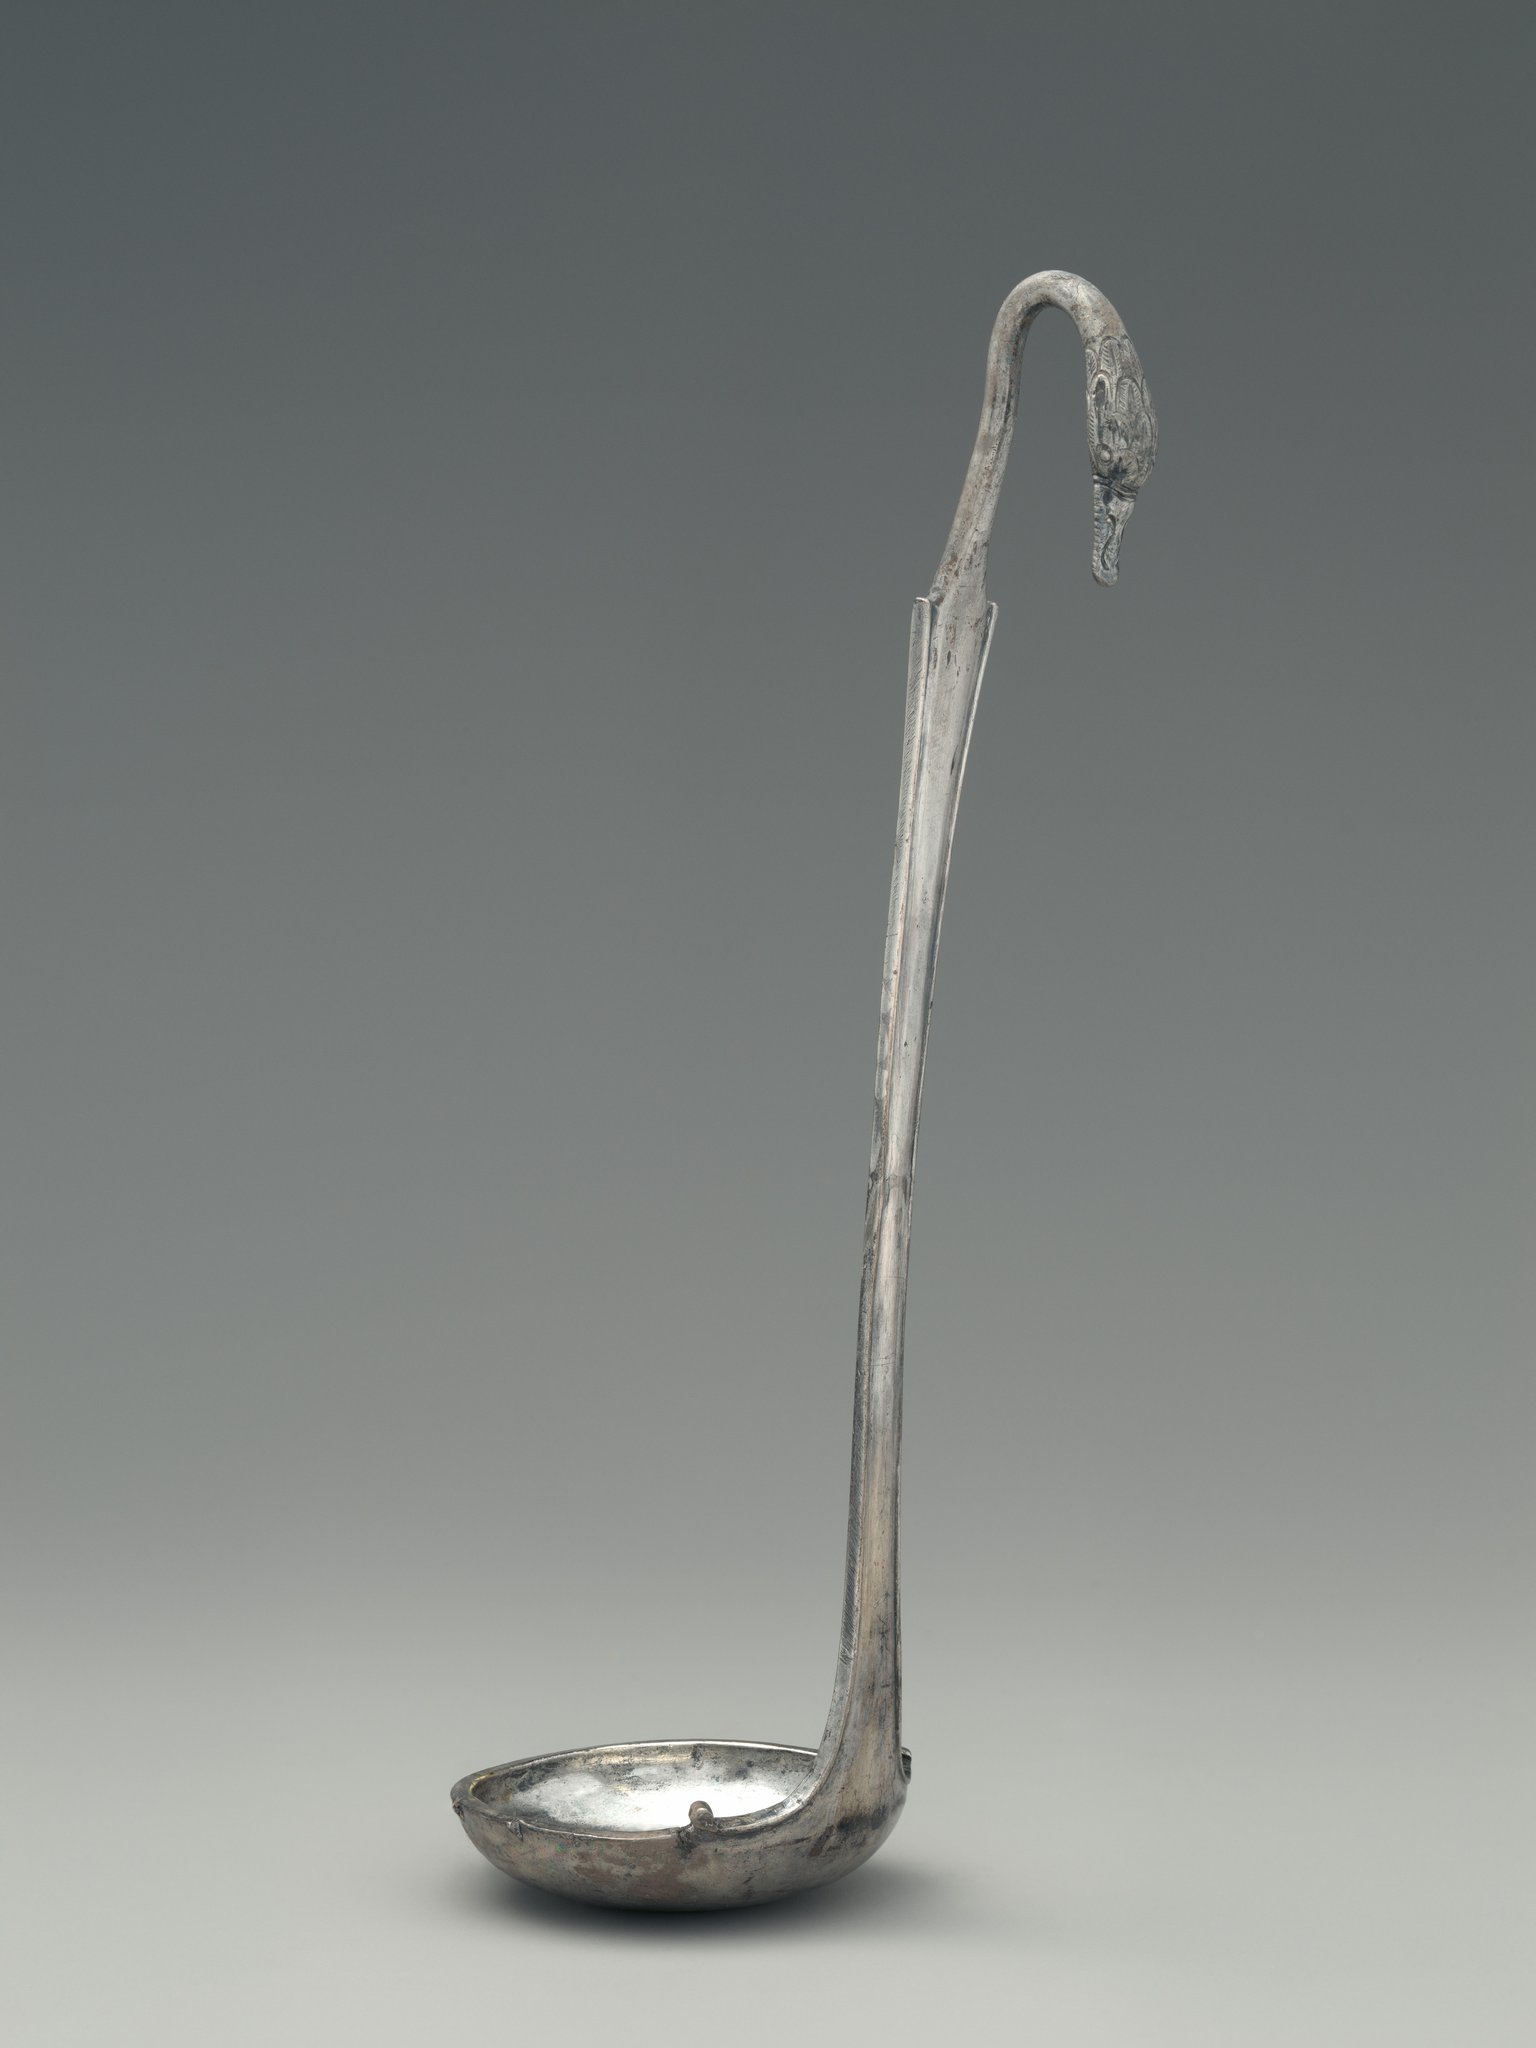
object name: ladle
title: Silver kyathos (cup-shaped ladle)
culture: greek or south italian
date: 334-301 BCE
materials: silver